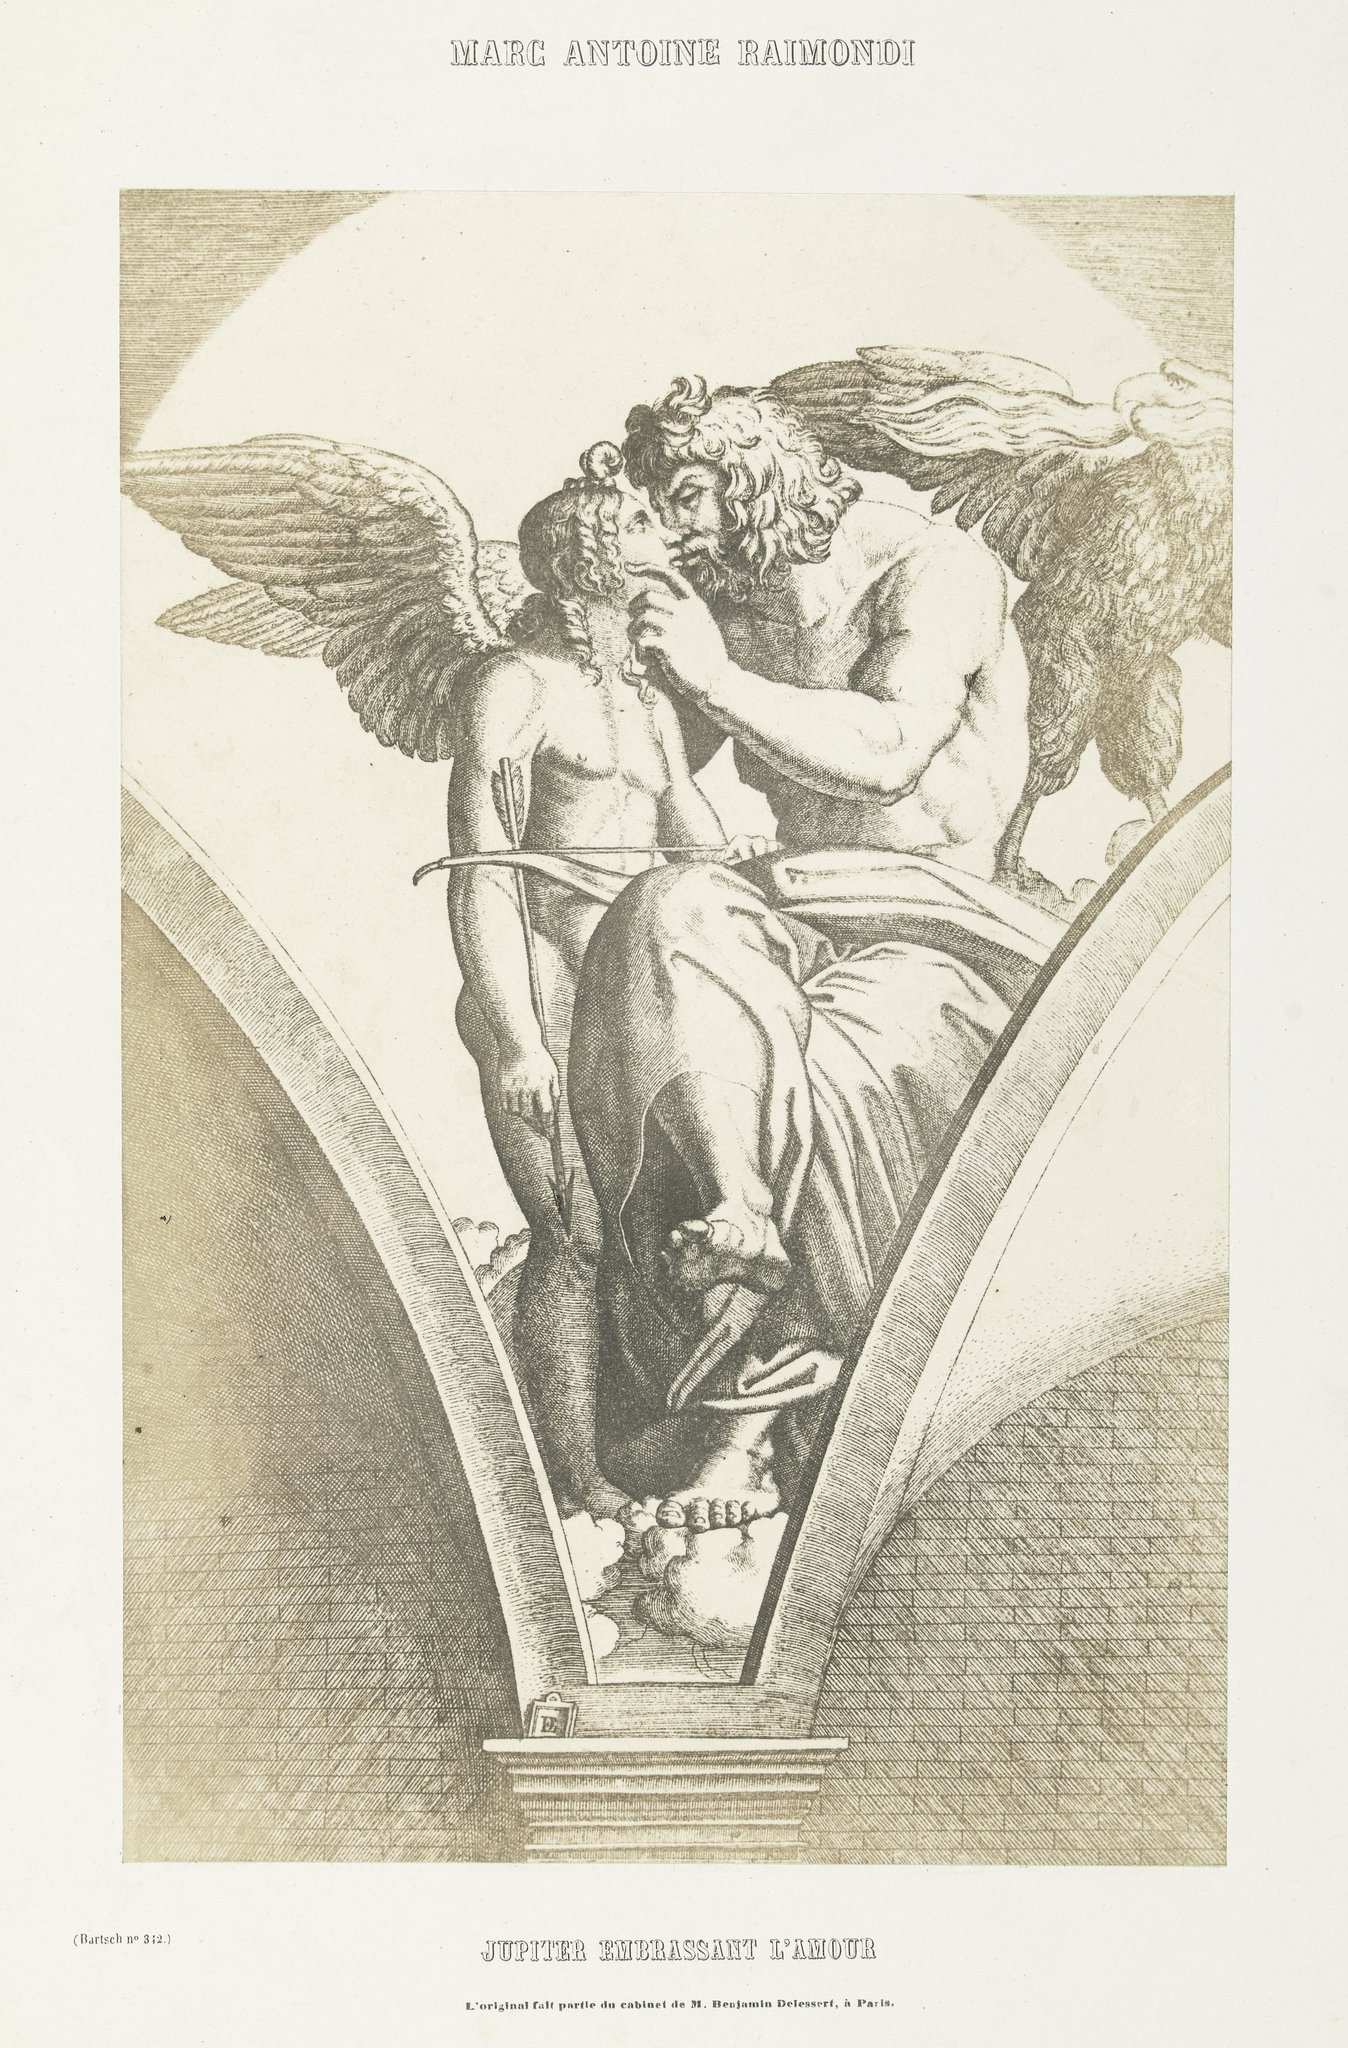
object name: photograph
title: Jupiter embrassant l'amour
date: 1853-1854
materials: paper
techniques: salted paper print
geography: london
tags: (story of) jupiter (zeus)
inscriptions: inscription: ‘(Bartsch no 312.)’, inscription: ‘L'original fait partie du cabinet de M. Benjamin Delessert, à Paris.’